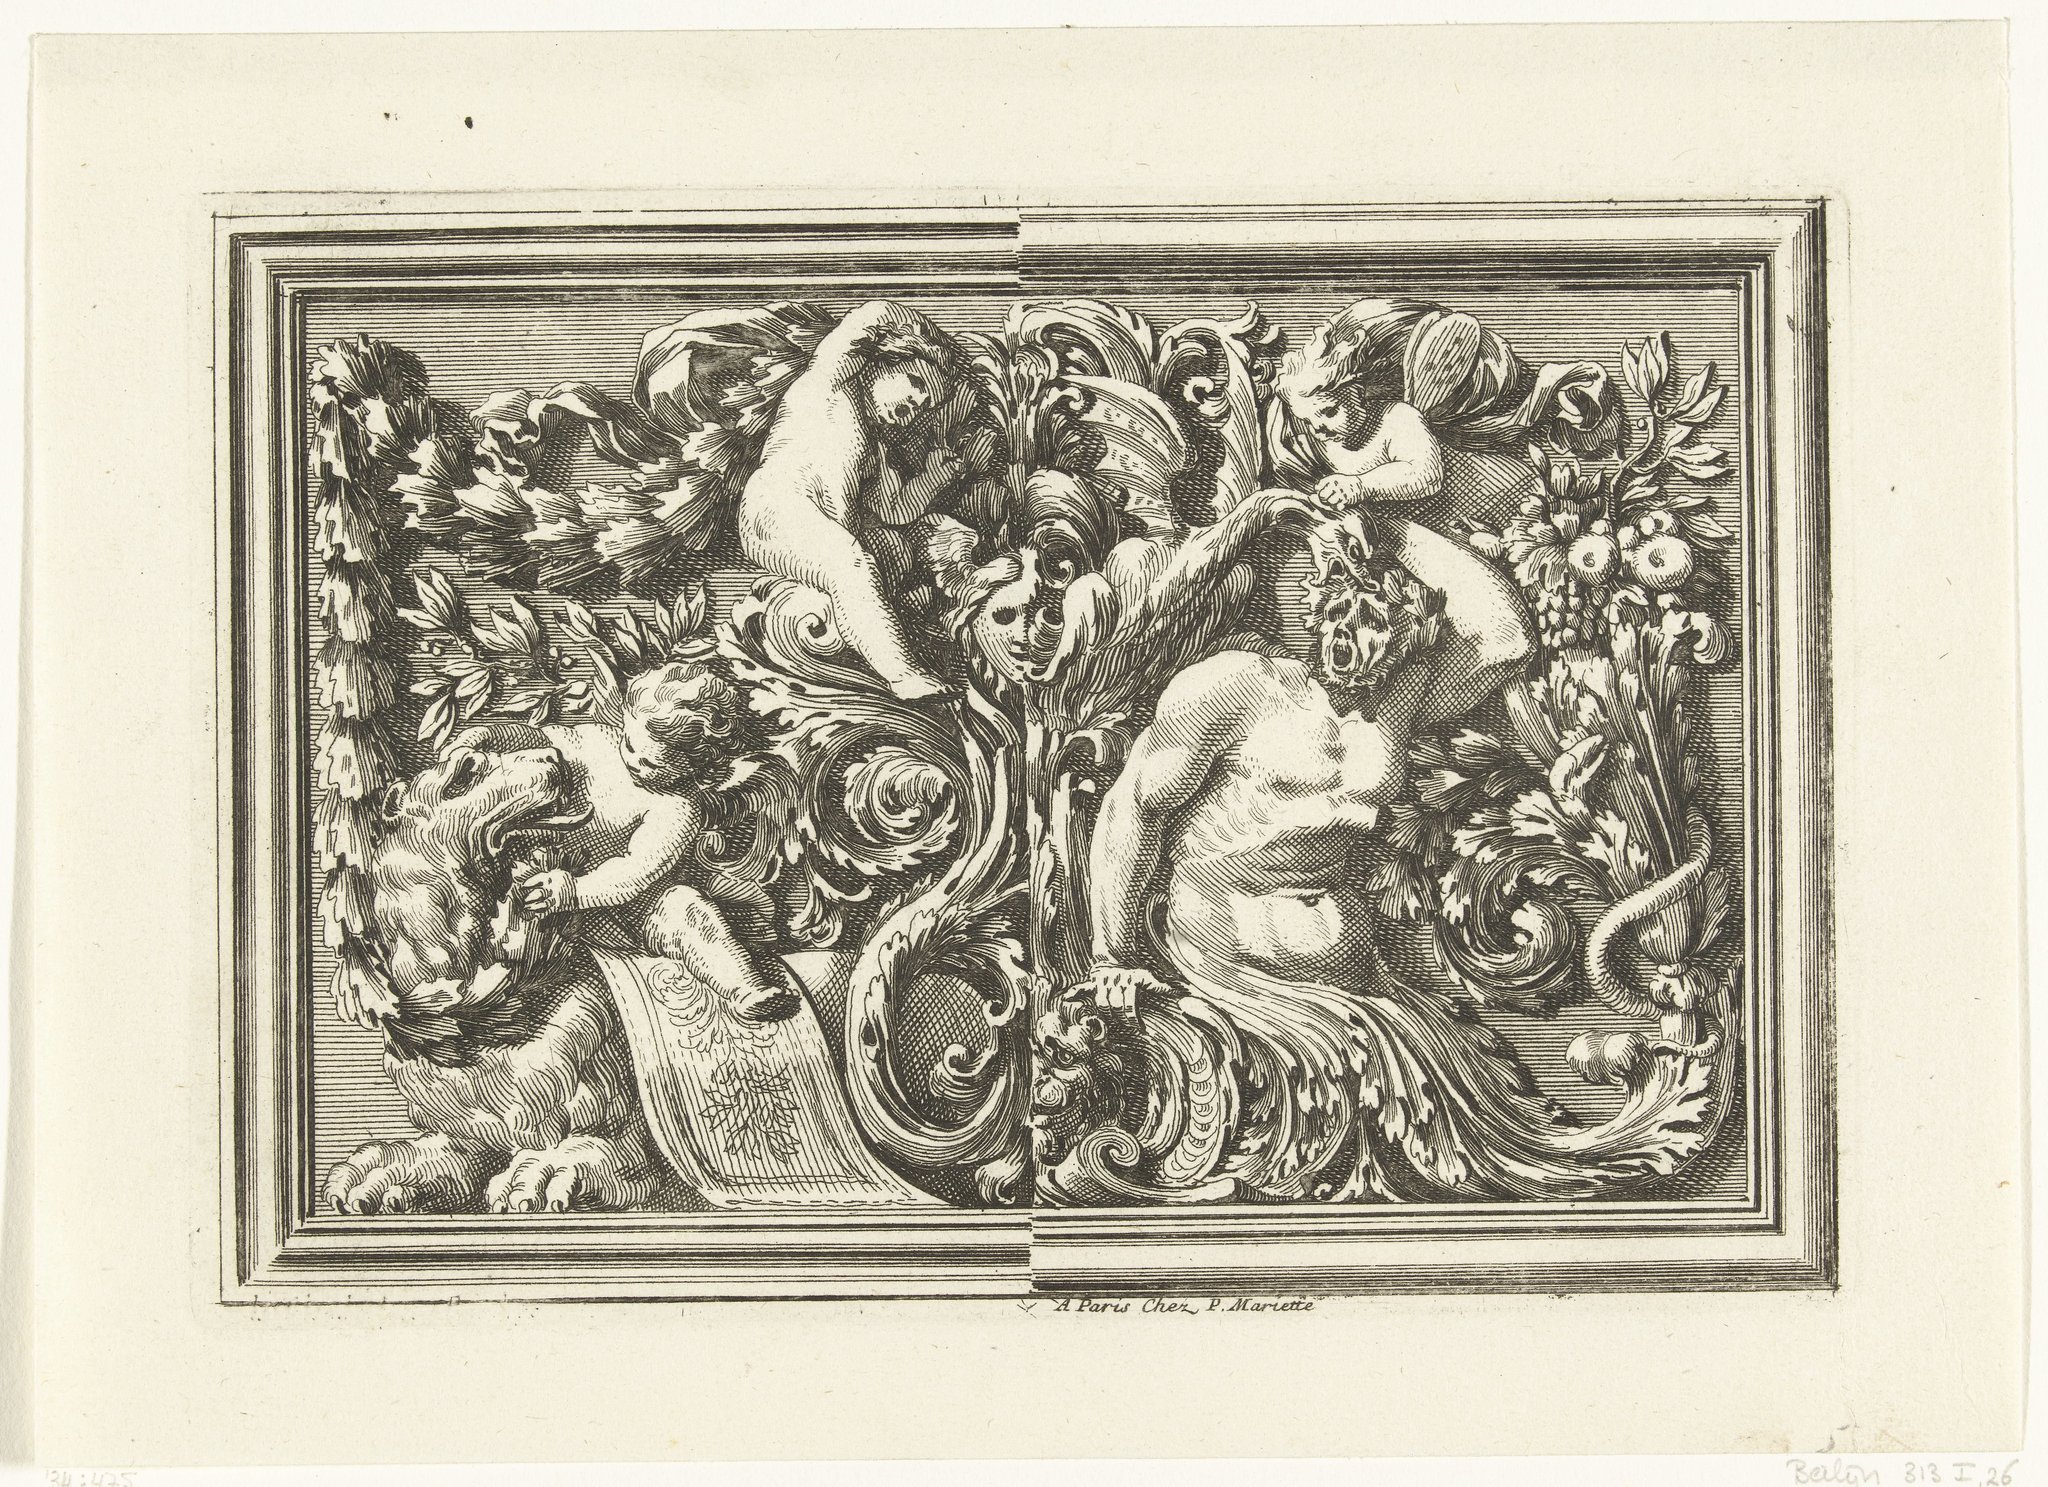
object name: print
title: Ornements de paneaux a la Romaine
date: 1667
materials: paper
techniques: etching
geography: france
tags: beasts of prey, predatory animals: lion, cupids: 'amores', 'amoretti', 'putti'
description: Blad 7 uit serie van 8(?) ornamentele panelen in de klassieke stijl. Op elk blad staat een variant voor de rechterhelft, aangegeven met de letter b in de bovenste marge. Uit tweede editie.